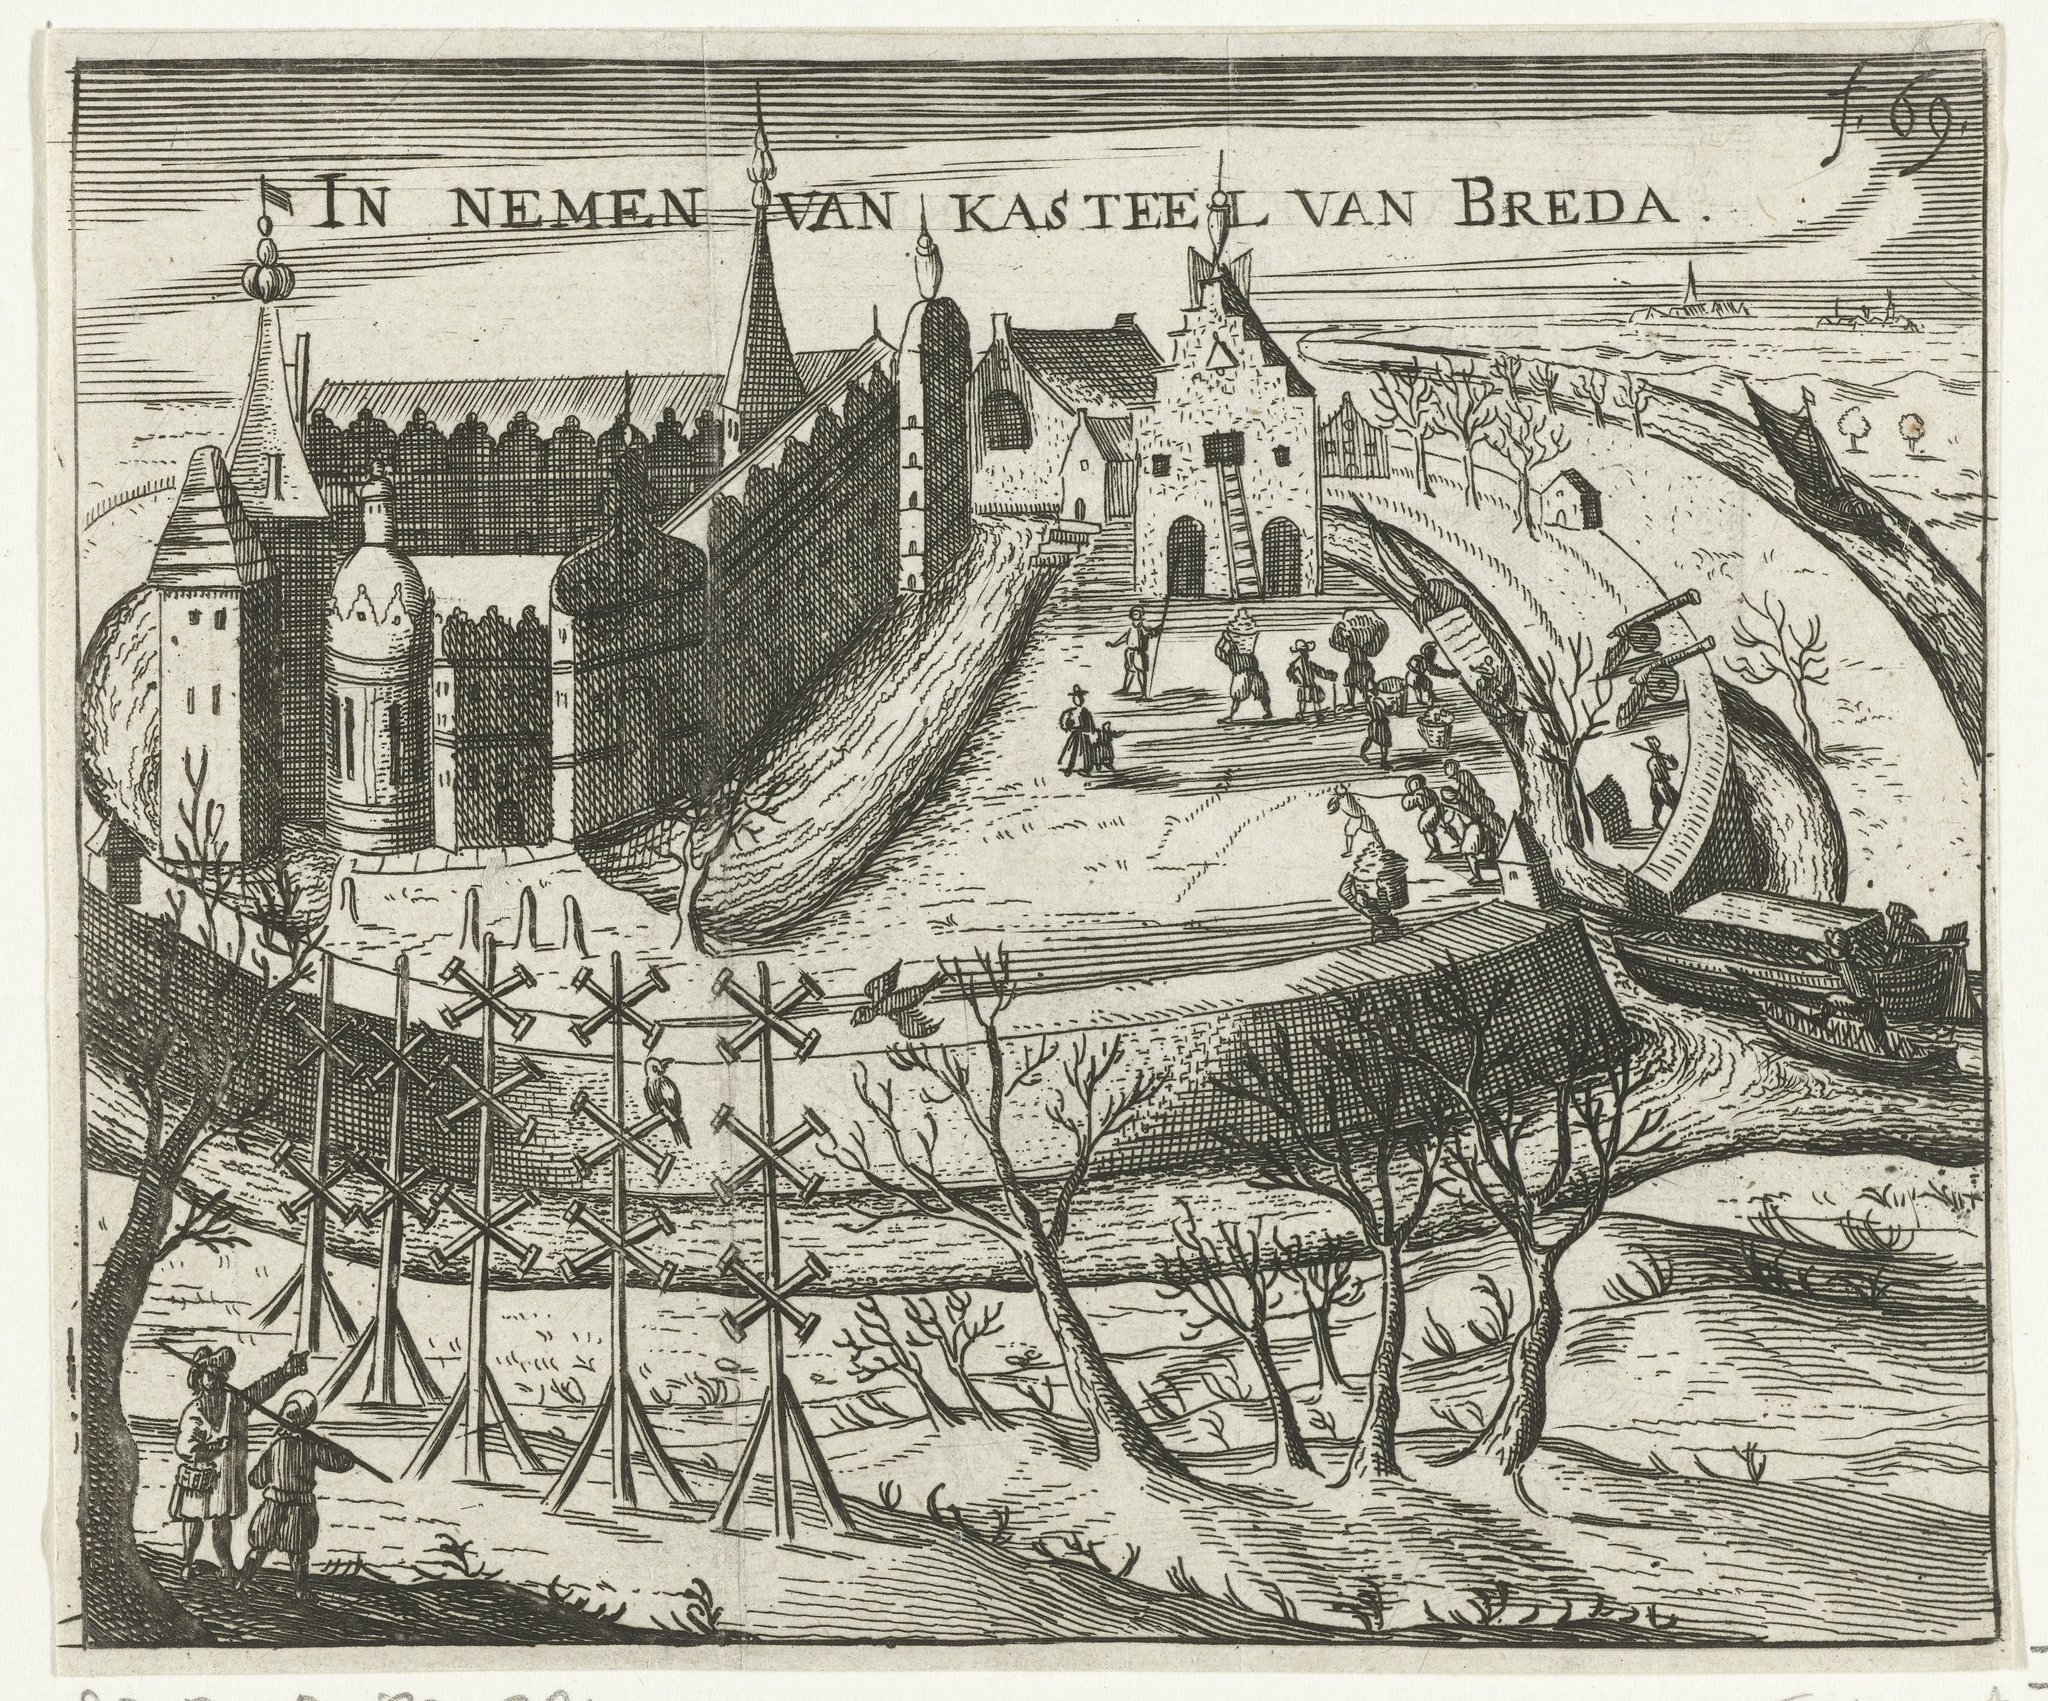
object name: print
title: In nemen van kasteel van Breda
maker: Anonymous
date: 1601-1649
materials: paper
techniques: etching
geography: northern netherlands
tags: maurice (prince of orange)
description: De inname van Breda door het Staatse leger onder Maurits, 4 maart 1590. Het turfschip wordt de burcht ingetrokken. Op de voorgrond twee mannetjes bij de lijmstokken.